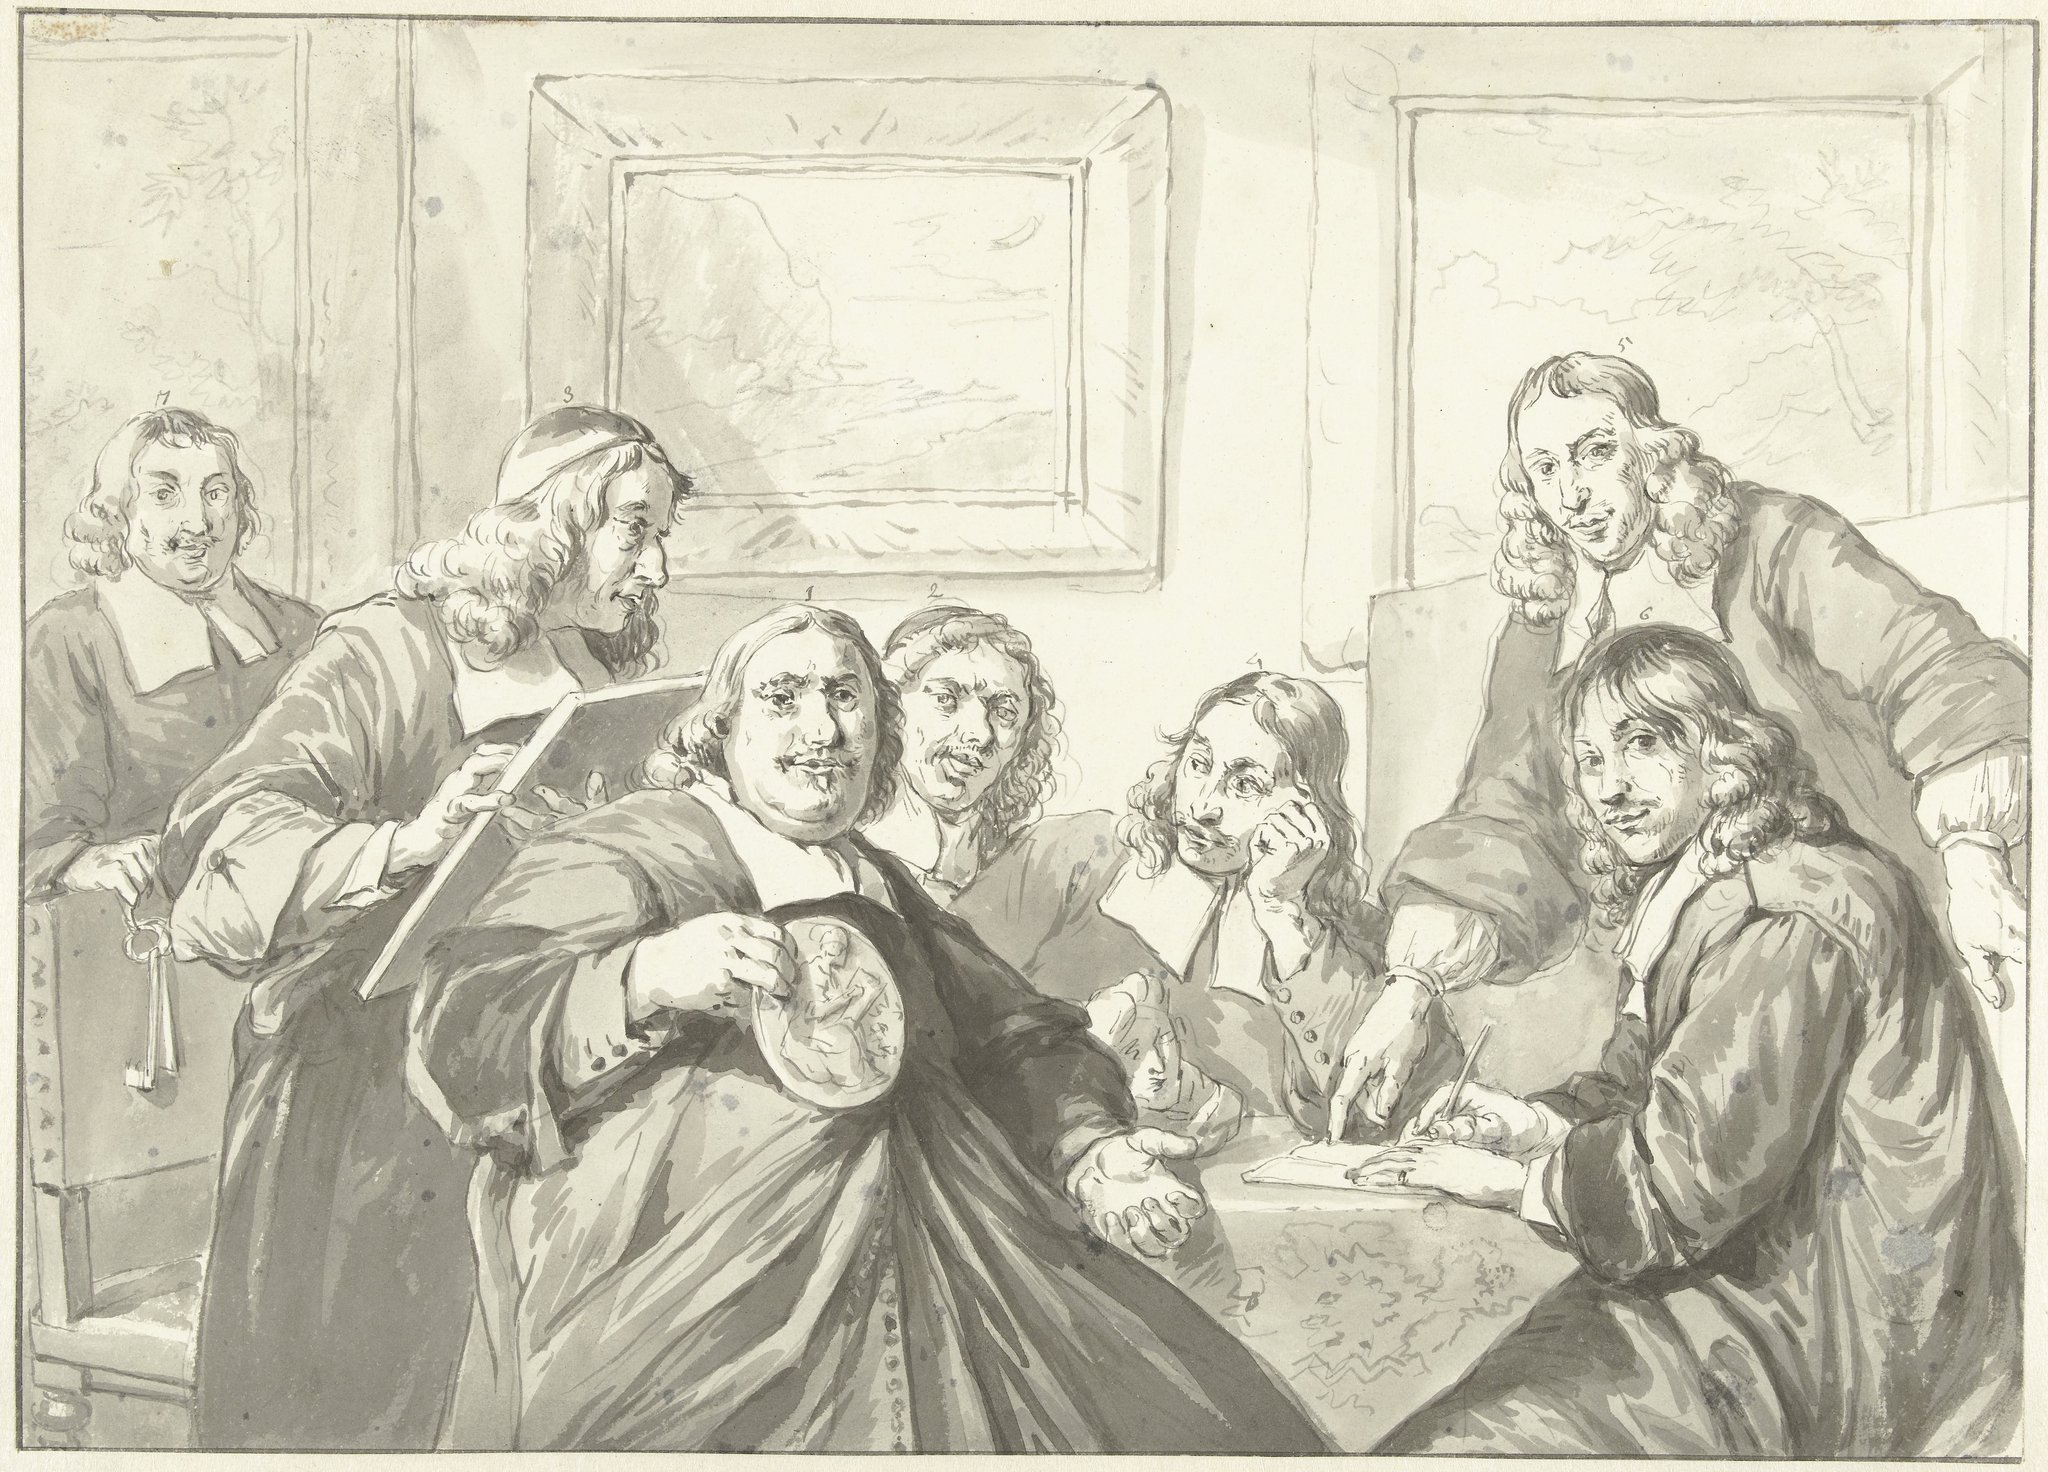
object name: drawing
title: De overlieden van het Sint Lucasgilde te Haarlem, 1675.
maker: wybrand hendriks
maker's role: draughtsman, painter, print maker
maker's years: 1744-1831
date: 1790-1810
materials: ink, paper, pencil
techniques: brush, pen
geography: netherlands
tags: amsterdam, jan de bray, haarlem, painter, print maker, draughtsman, dirck de bray, wouter knijff, historical persons, guild of st. luke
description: Groepsportret van de overlieden van het Sint Lucasgilde te Haarlem, 1675. Van links naar rechts: Wouter Knyff, Jan de Bray, Gerrit Mulraet, Jan Golingh, Jan Claesz Marselis, Dirck de Bray en Jan de Jongh. De zilversmid Mulraet houdt in zijn hand een gedreven plaque met een afbeelding van de heilige Lucas. Tegen de wand twee schilderijen met landschappen.